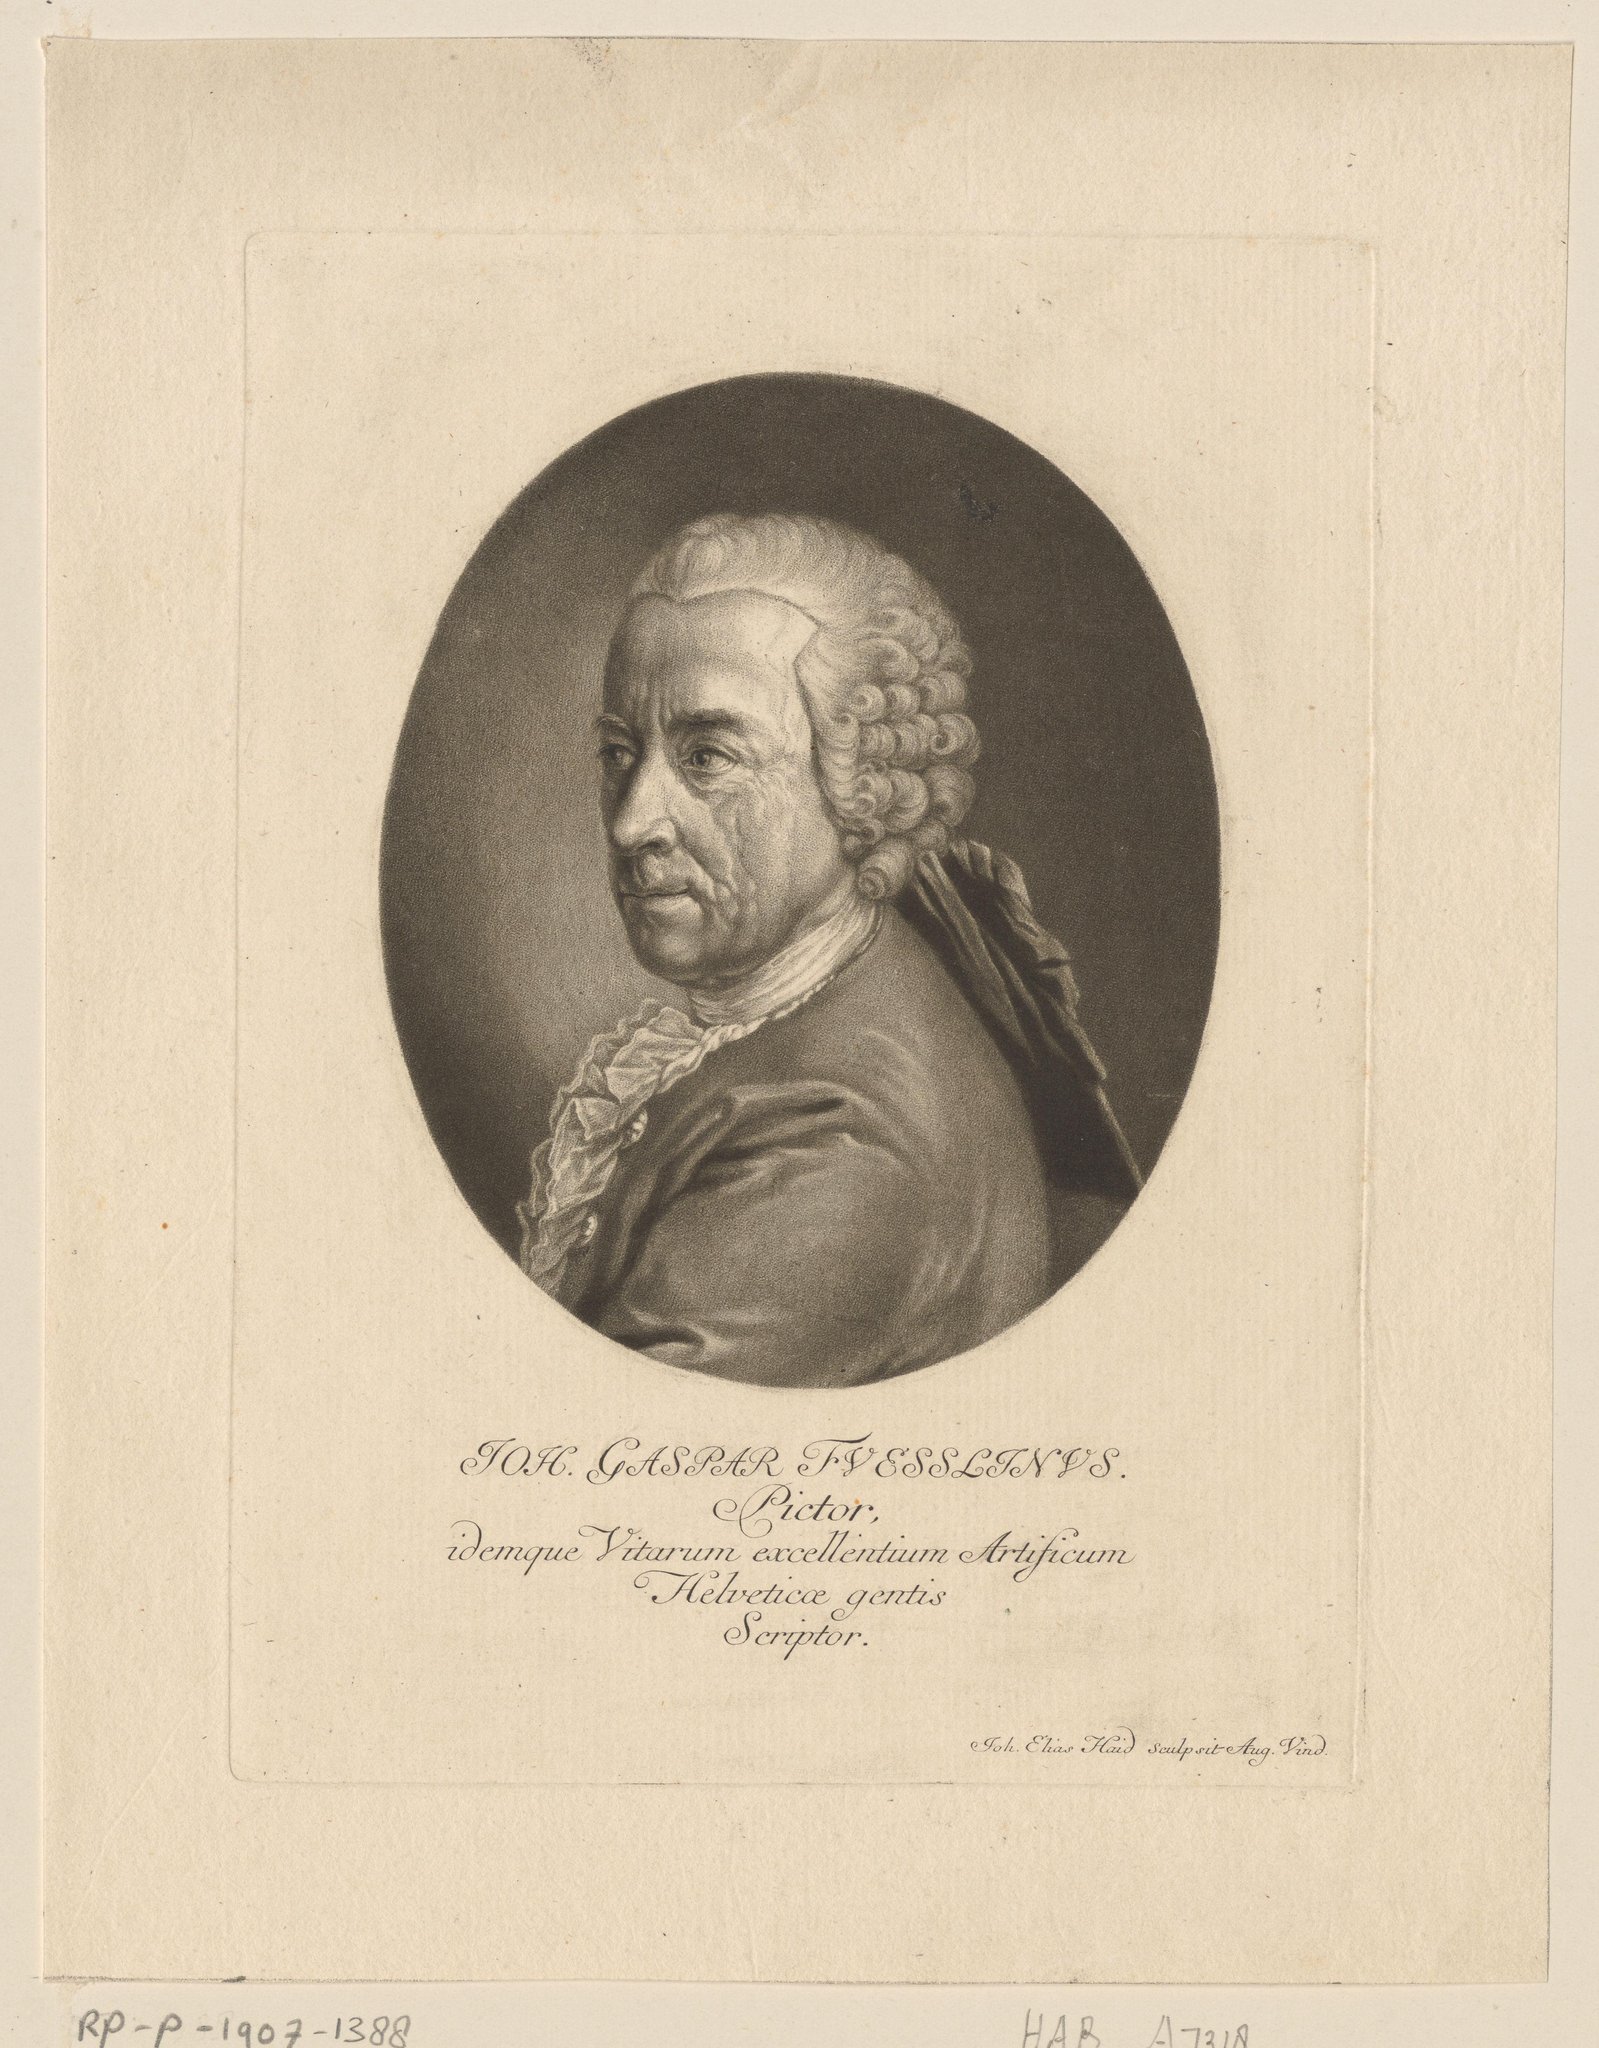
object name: print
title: Portret van Johann Caspar Füssli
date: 1778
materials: paper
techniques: mezzotint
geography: augsburg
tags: johann caspar füssli, historical persons, portrait, self-portrait of painter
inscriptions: collector's mark: Lugt 2228